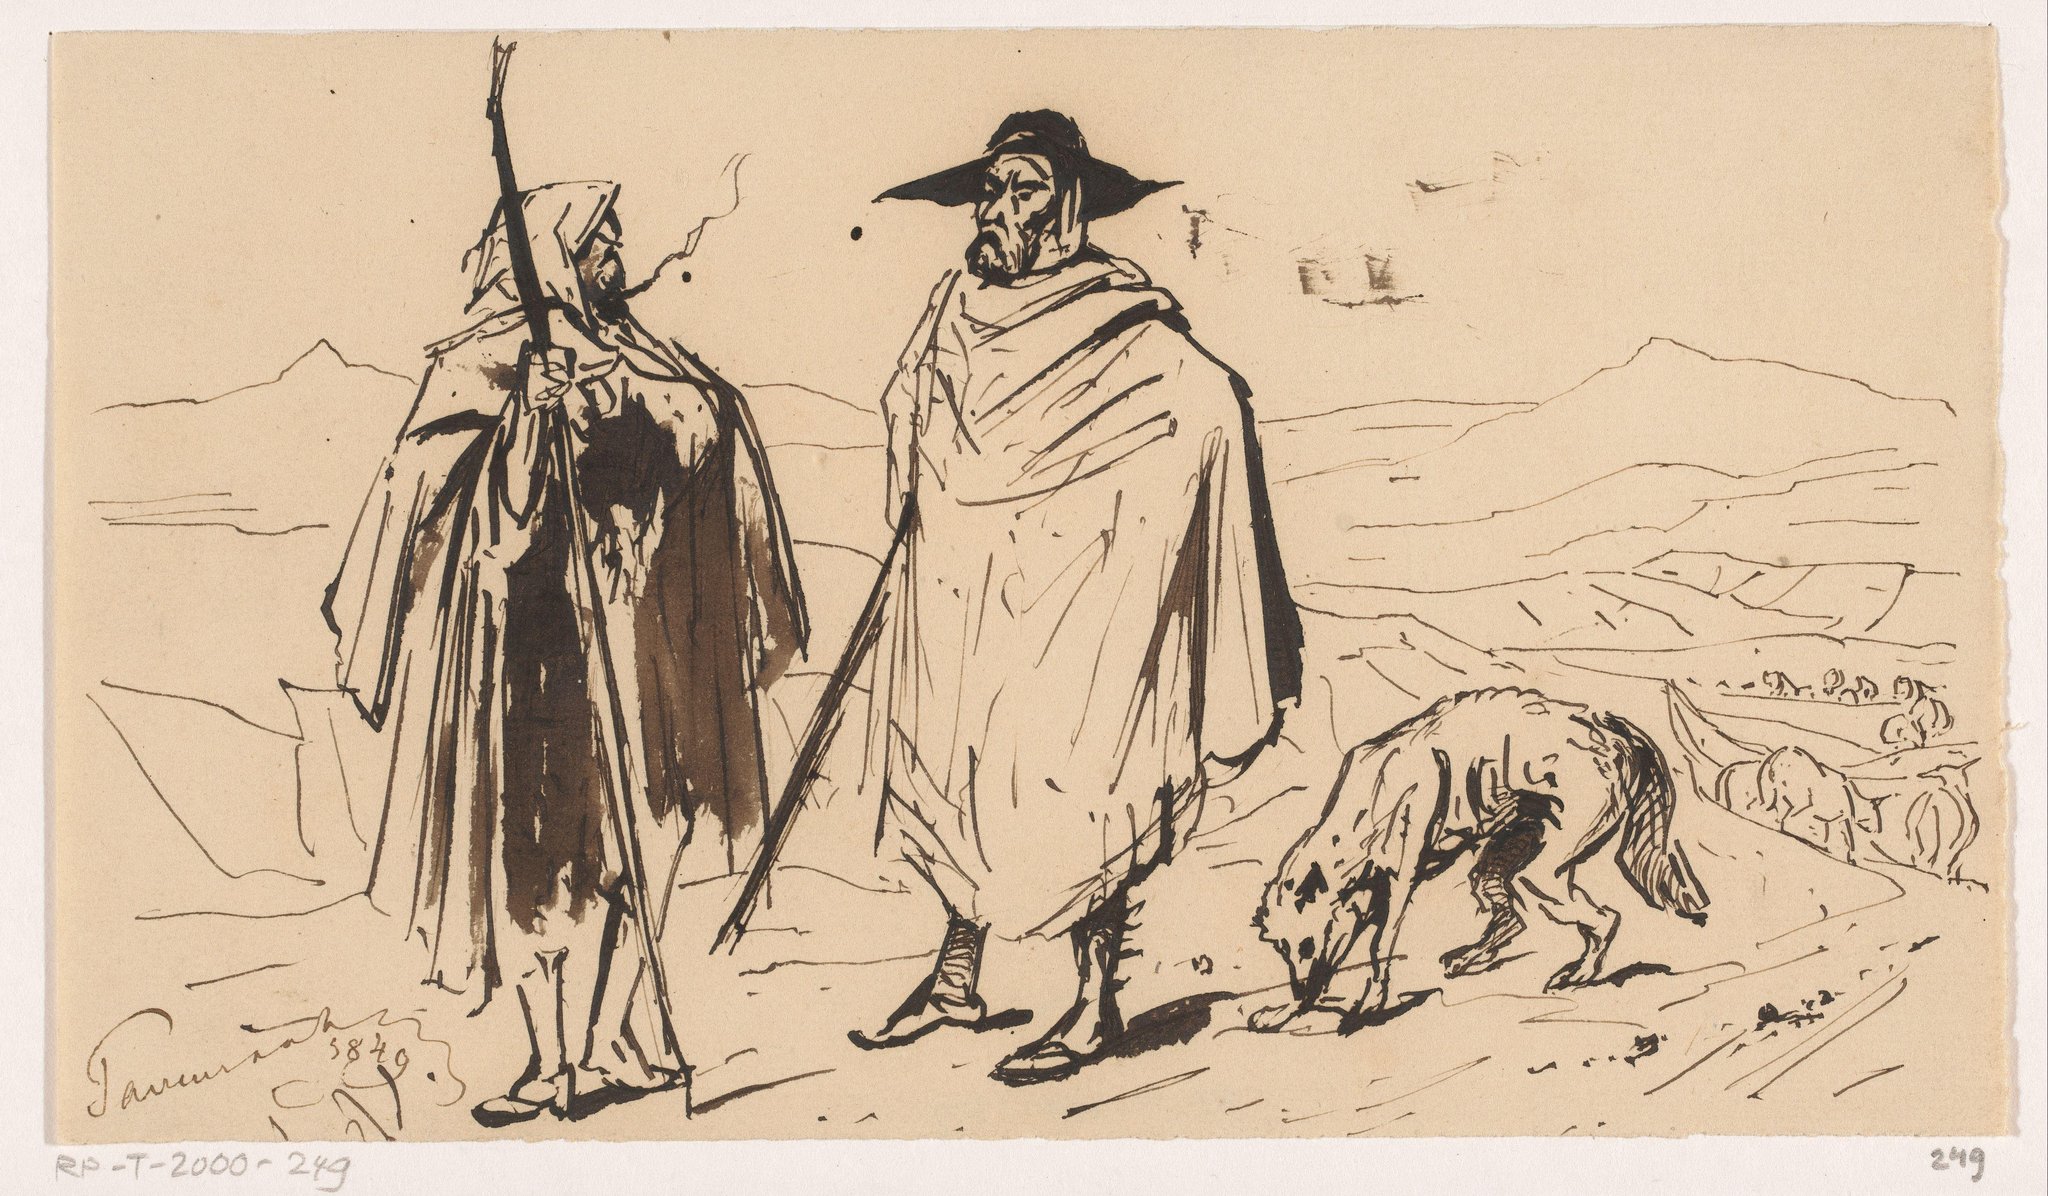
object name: drawing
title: Herder met hond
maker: johannes tavenraat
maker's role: draughtsman, painter, print maker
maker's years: 1809-1881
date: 1849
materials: ink, paper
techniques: brush, pen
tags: herding, herdsman, herdswoman, shepherd, shepherdess, cowherd, etc.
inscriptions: signature and date: ‘Tavenraat 1849’, collector's mark: Lugt 2228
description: Herder in lange mantel, staf en hoed met hond op een weg in heuvellandschap. De herder twee maal getekend.